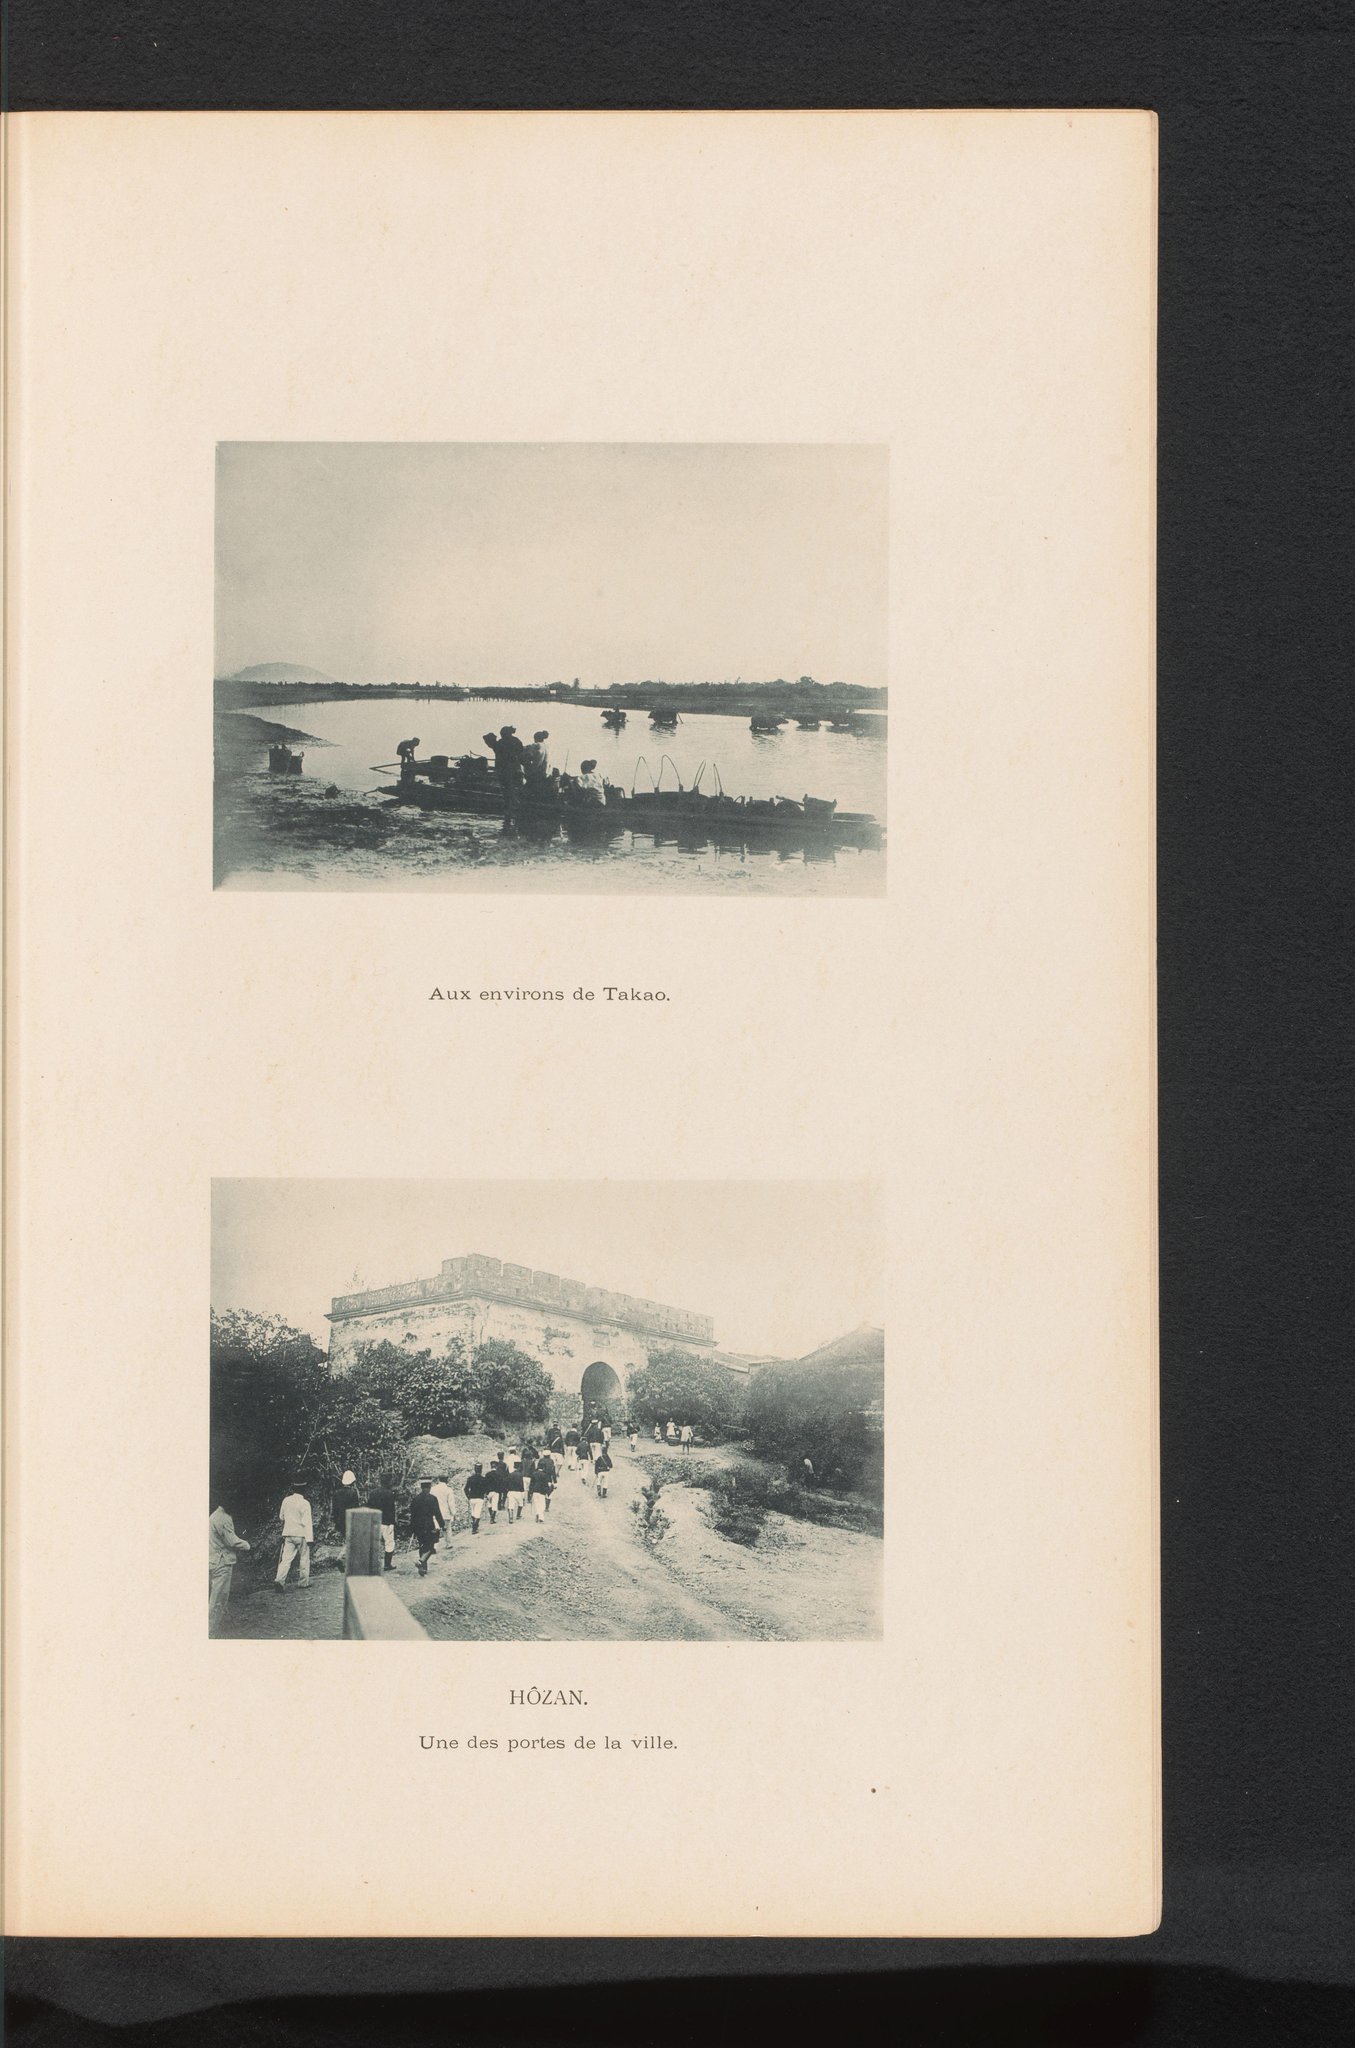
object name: page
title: Hôzan. Une des portes de la ville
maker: Anonymous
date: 1891-1896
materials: paper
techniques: photograph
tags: fisherman, city-gate (+ city(-scape) with figures, staffage)